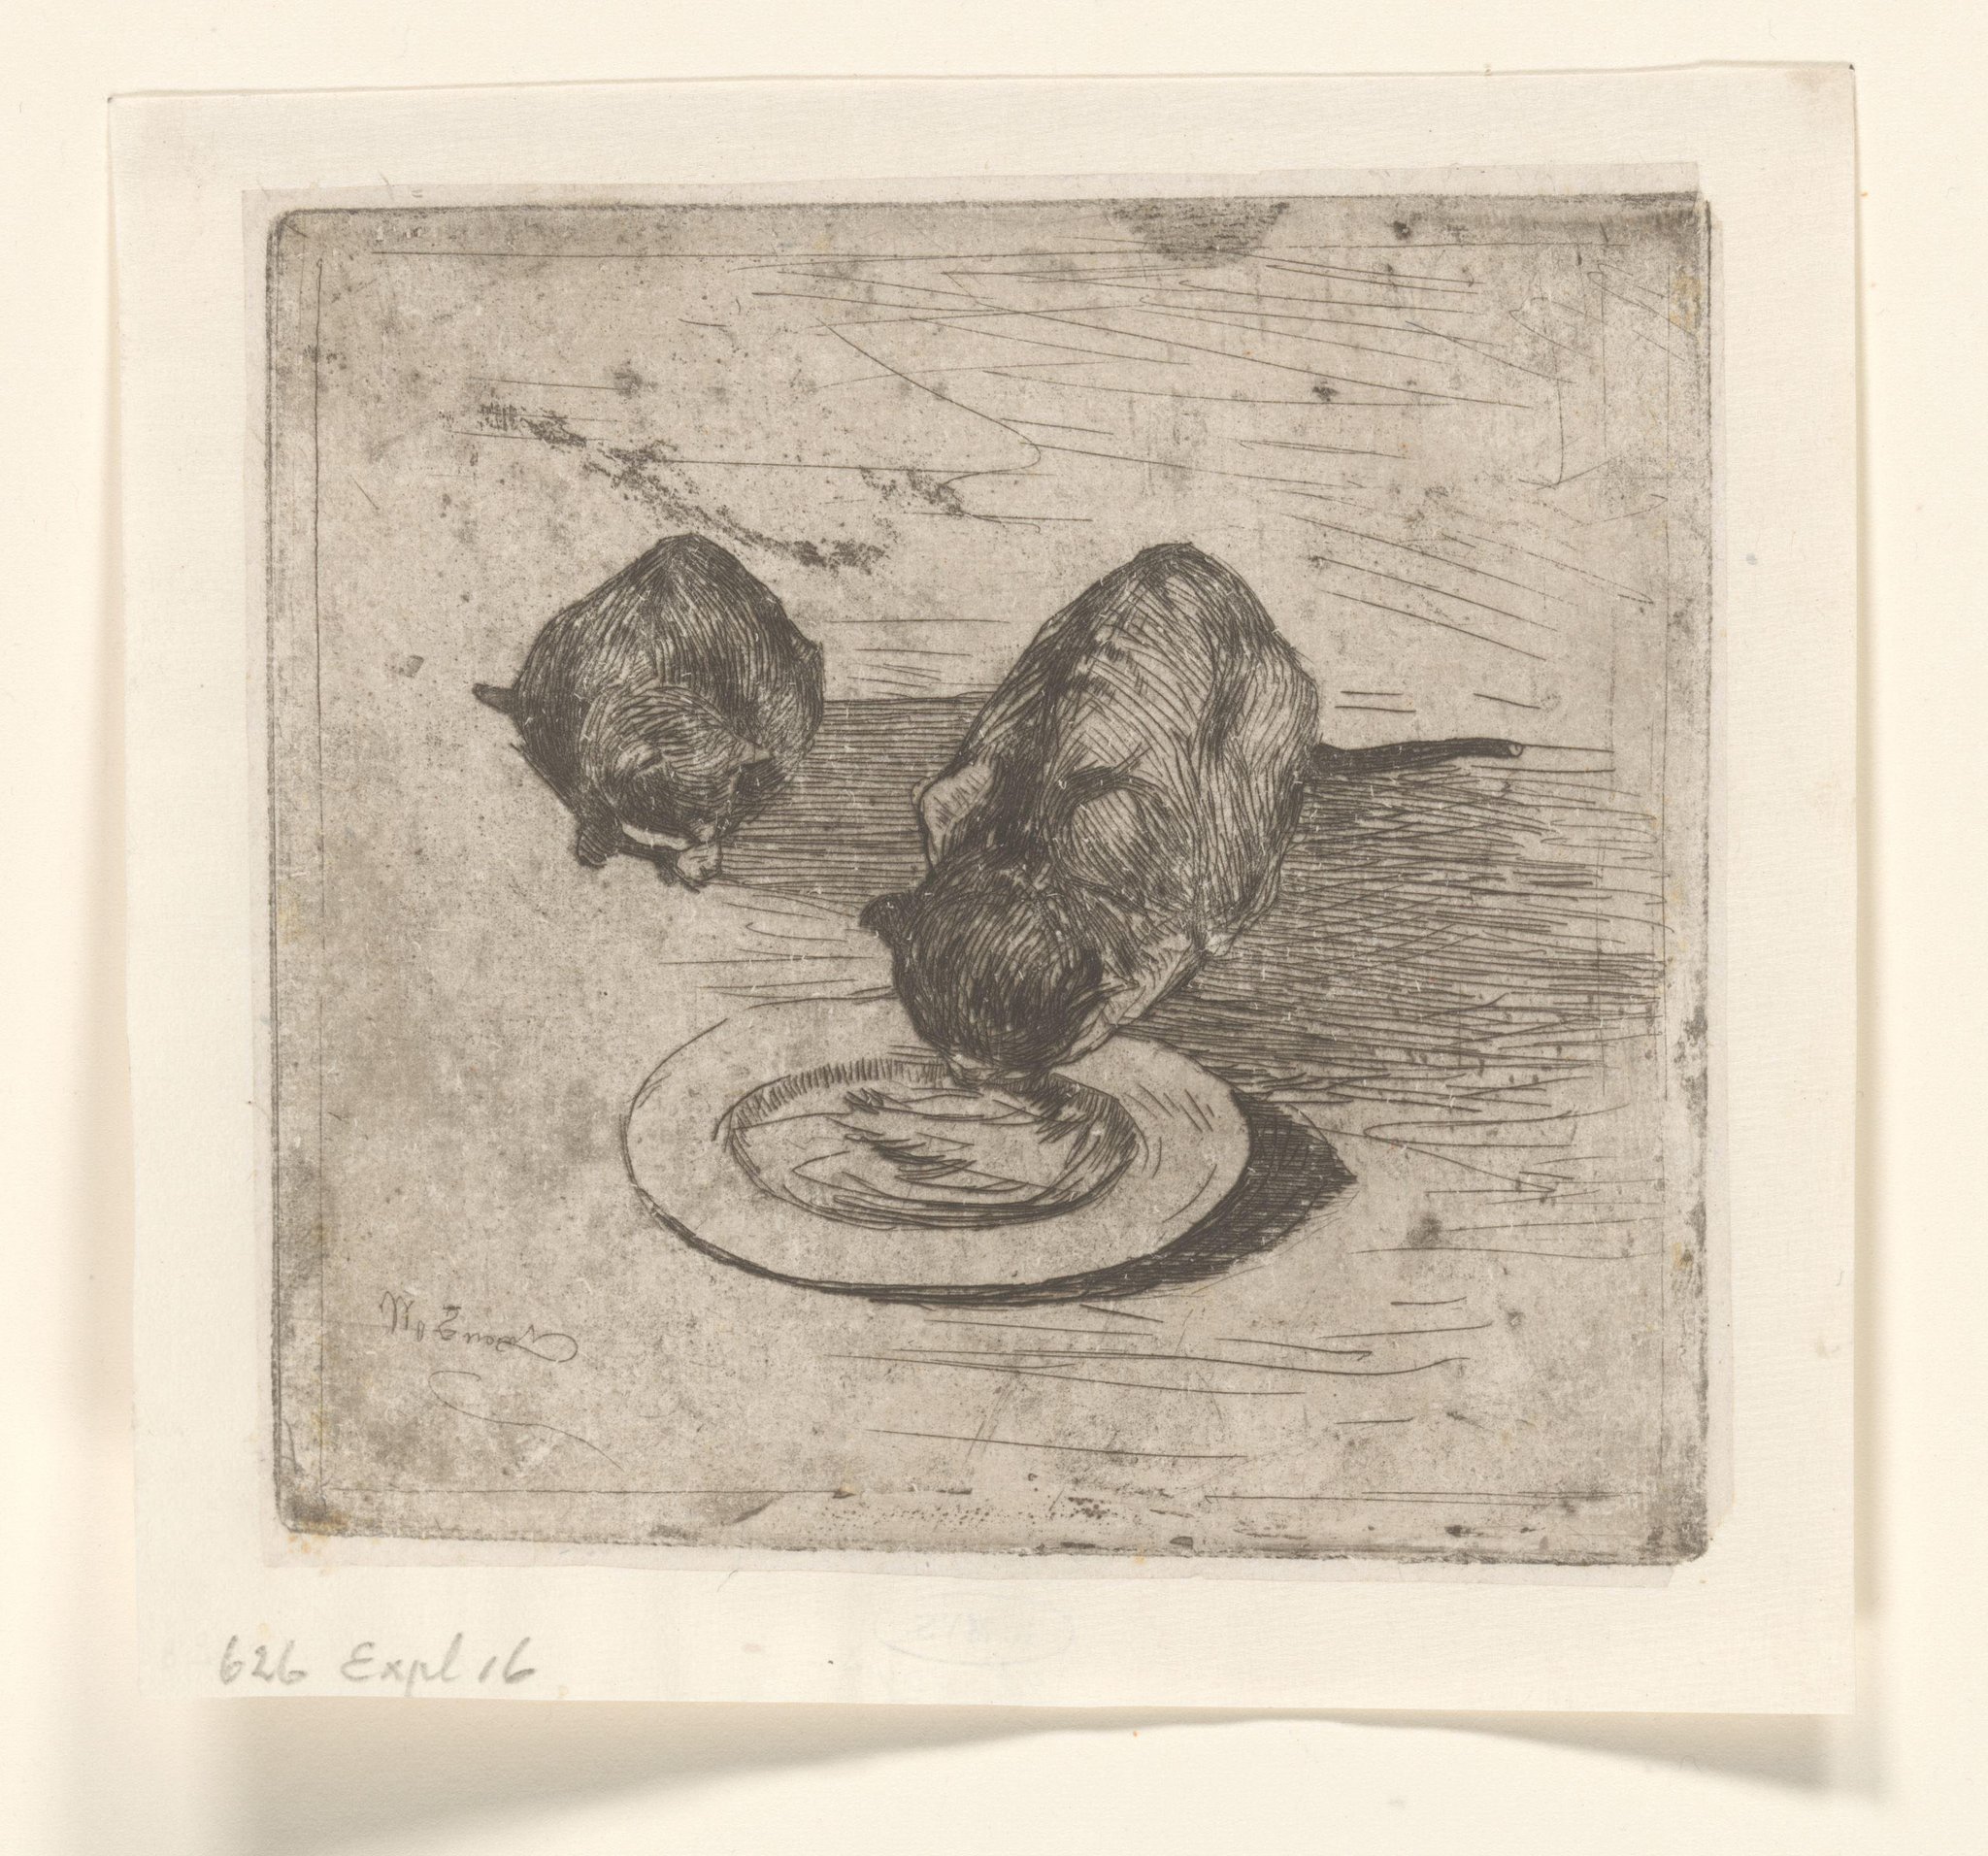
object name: print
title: Twee katten, één drinkend uit een bord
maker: willem de zwart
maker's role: draughtsman, painter, print maker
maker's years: 1862-1931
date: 1885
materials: paper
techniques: etching, intaglio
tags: cat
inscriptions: collector's mark: Lugt 2228